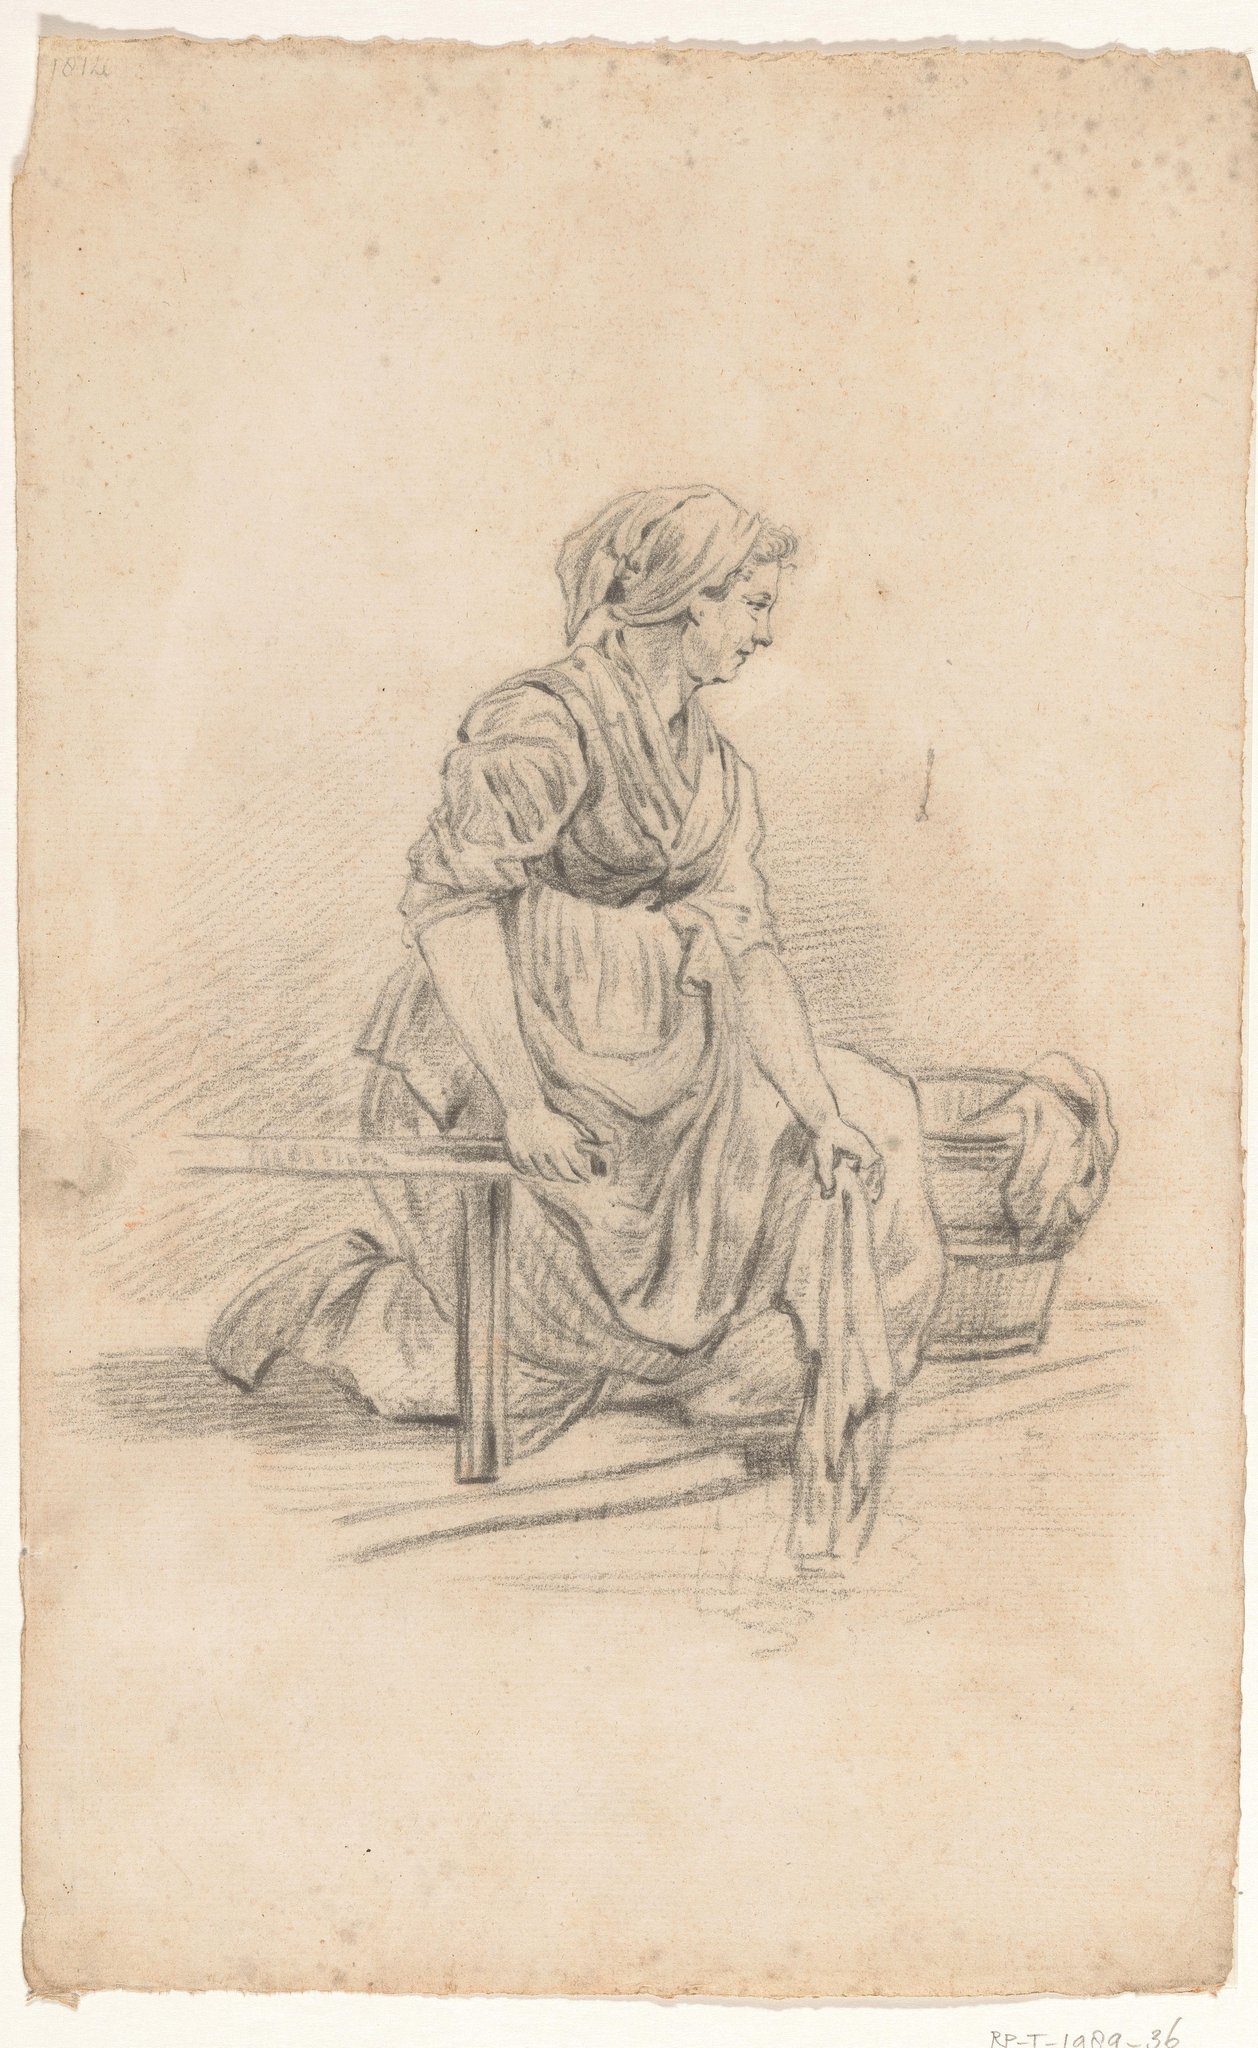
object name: drawing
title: Geknielde vrouw met was aan het water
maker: Anonymous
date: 1700-1800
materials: chalk, paper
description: Geknielde vrouw met was op een vlonder aan het water.